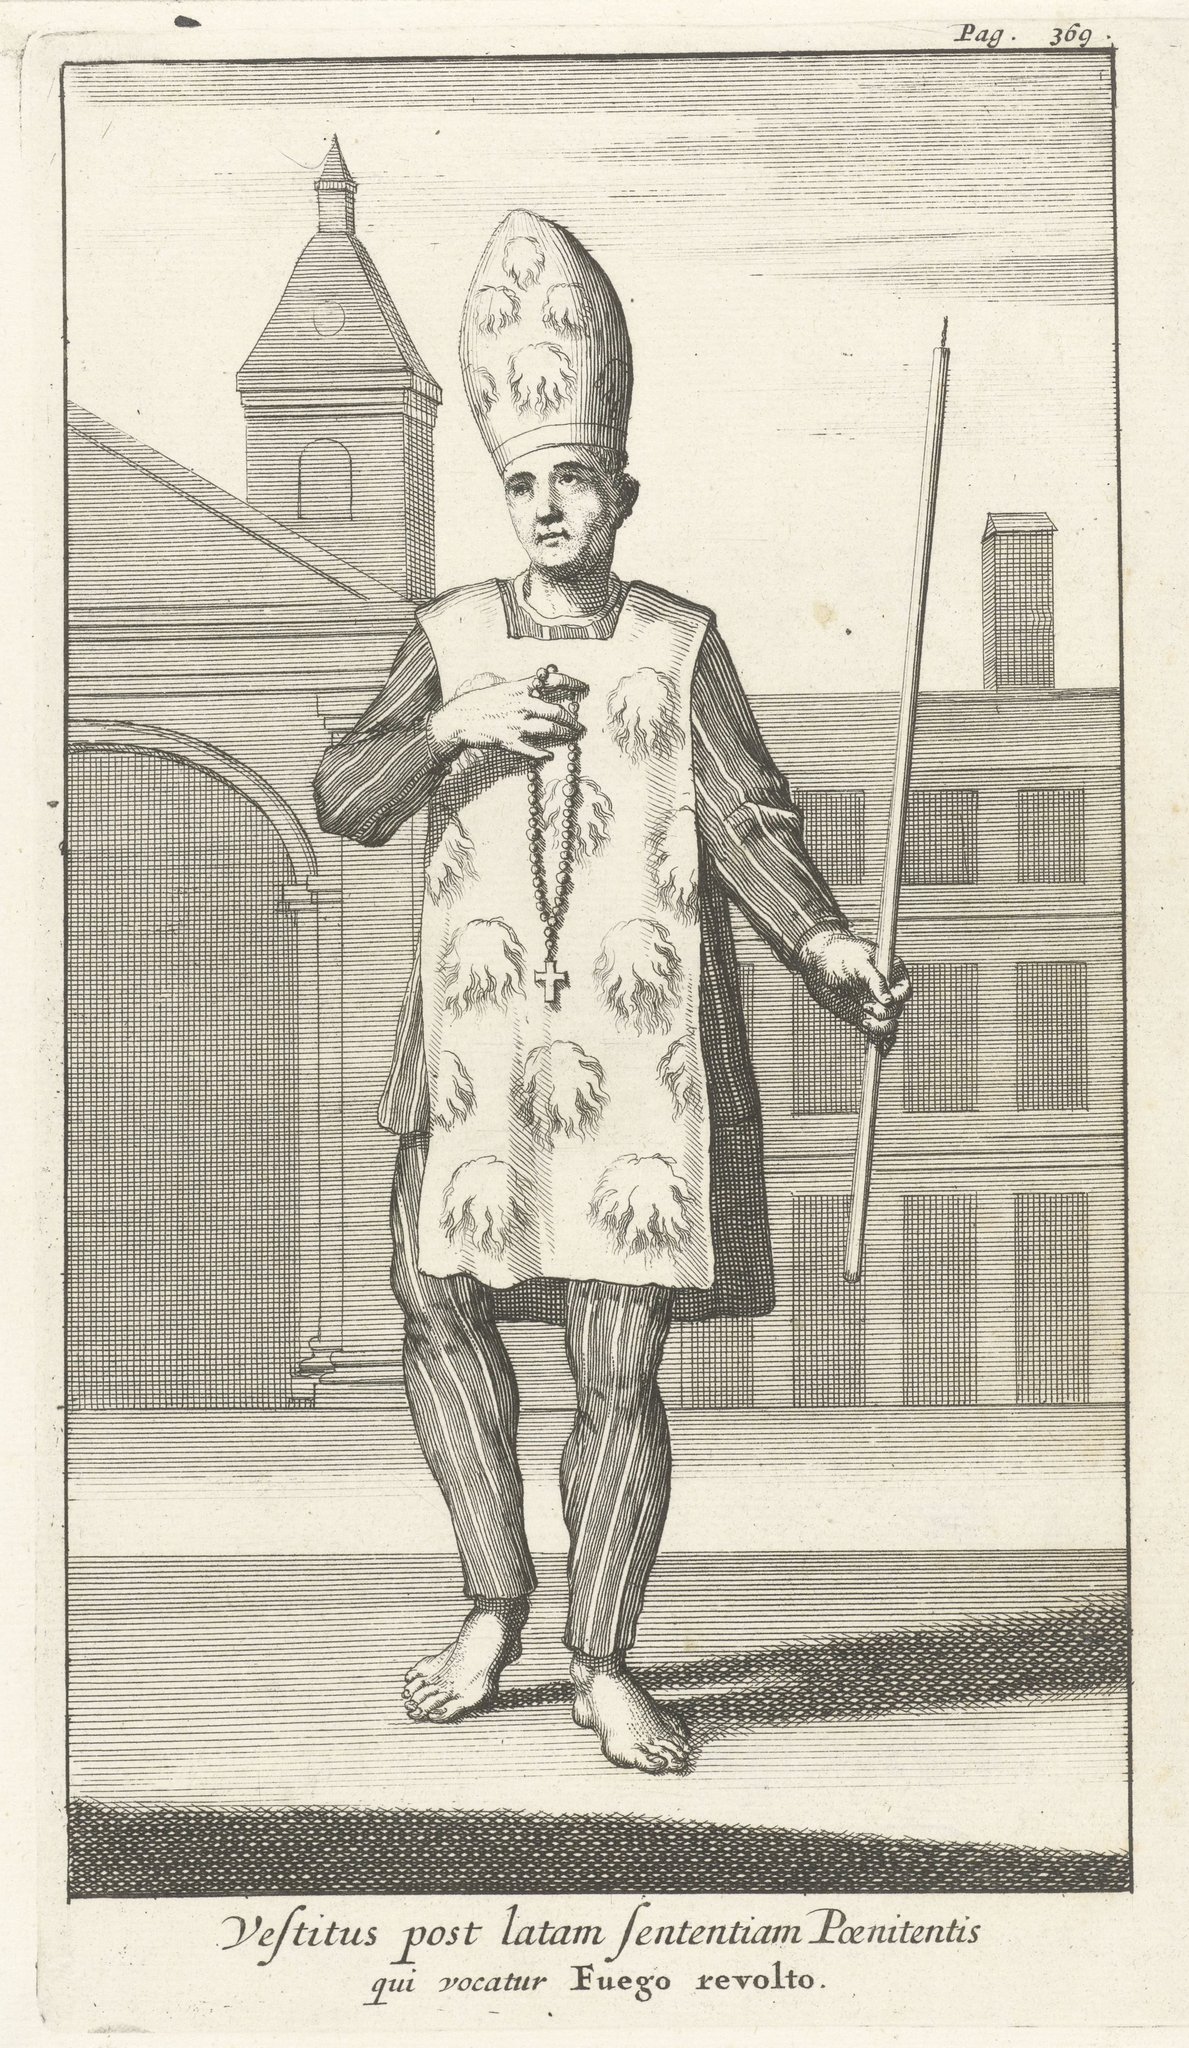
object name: book illustration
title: Vestitus post latam sententiam Poenitentis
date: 1692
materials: paper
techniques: etching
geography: amsterdam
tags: public penance, general avowal of faults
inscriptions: collector's mark: Lugt 2228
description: Illustratie uit: Limborch, Philippus van. Historia inquisitionis. Amsterdam: Henricus Wetstein, 1692.